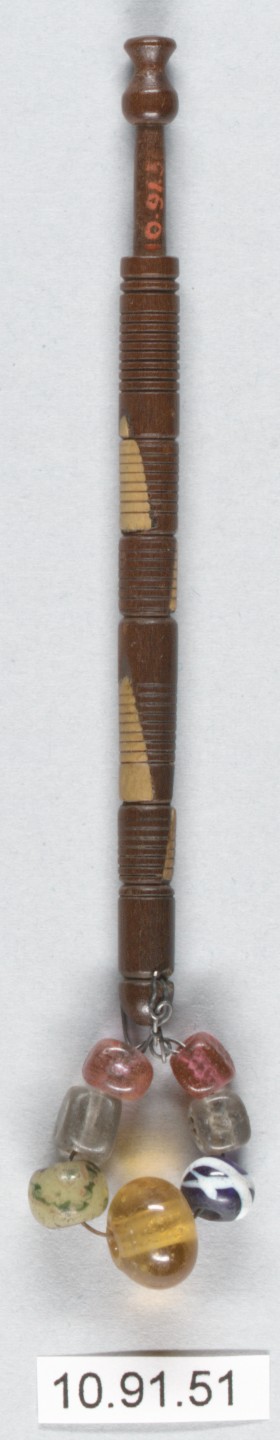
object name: bobbin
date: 1801-1900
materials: wood